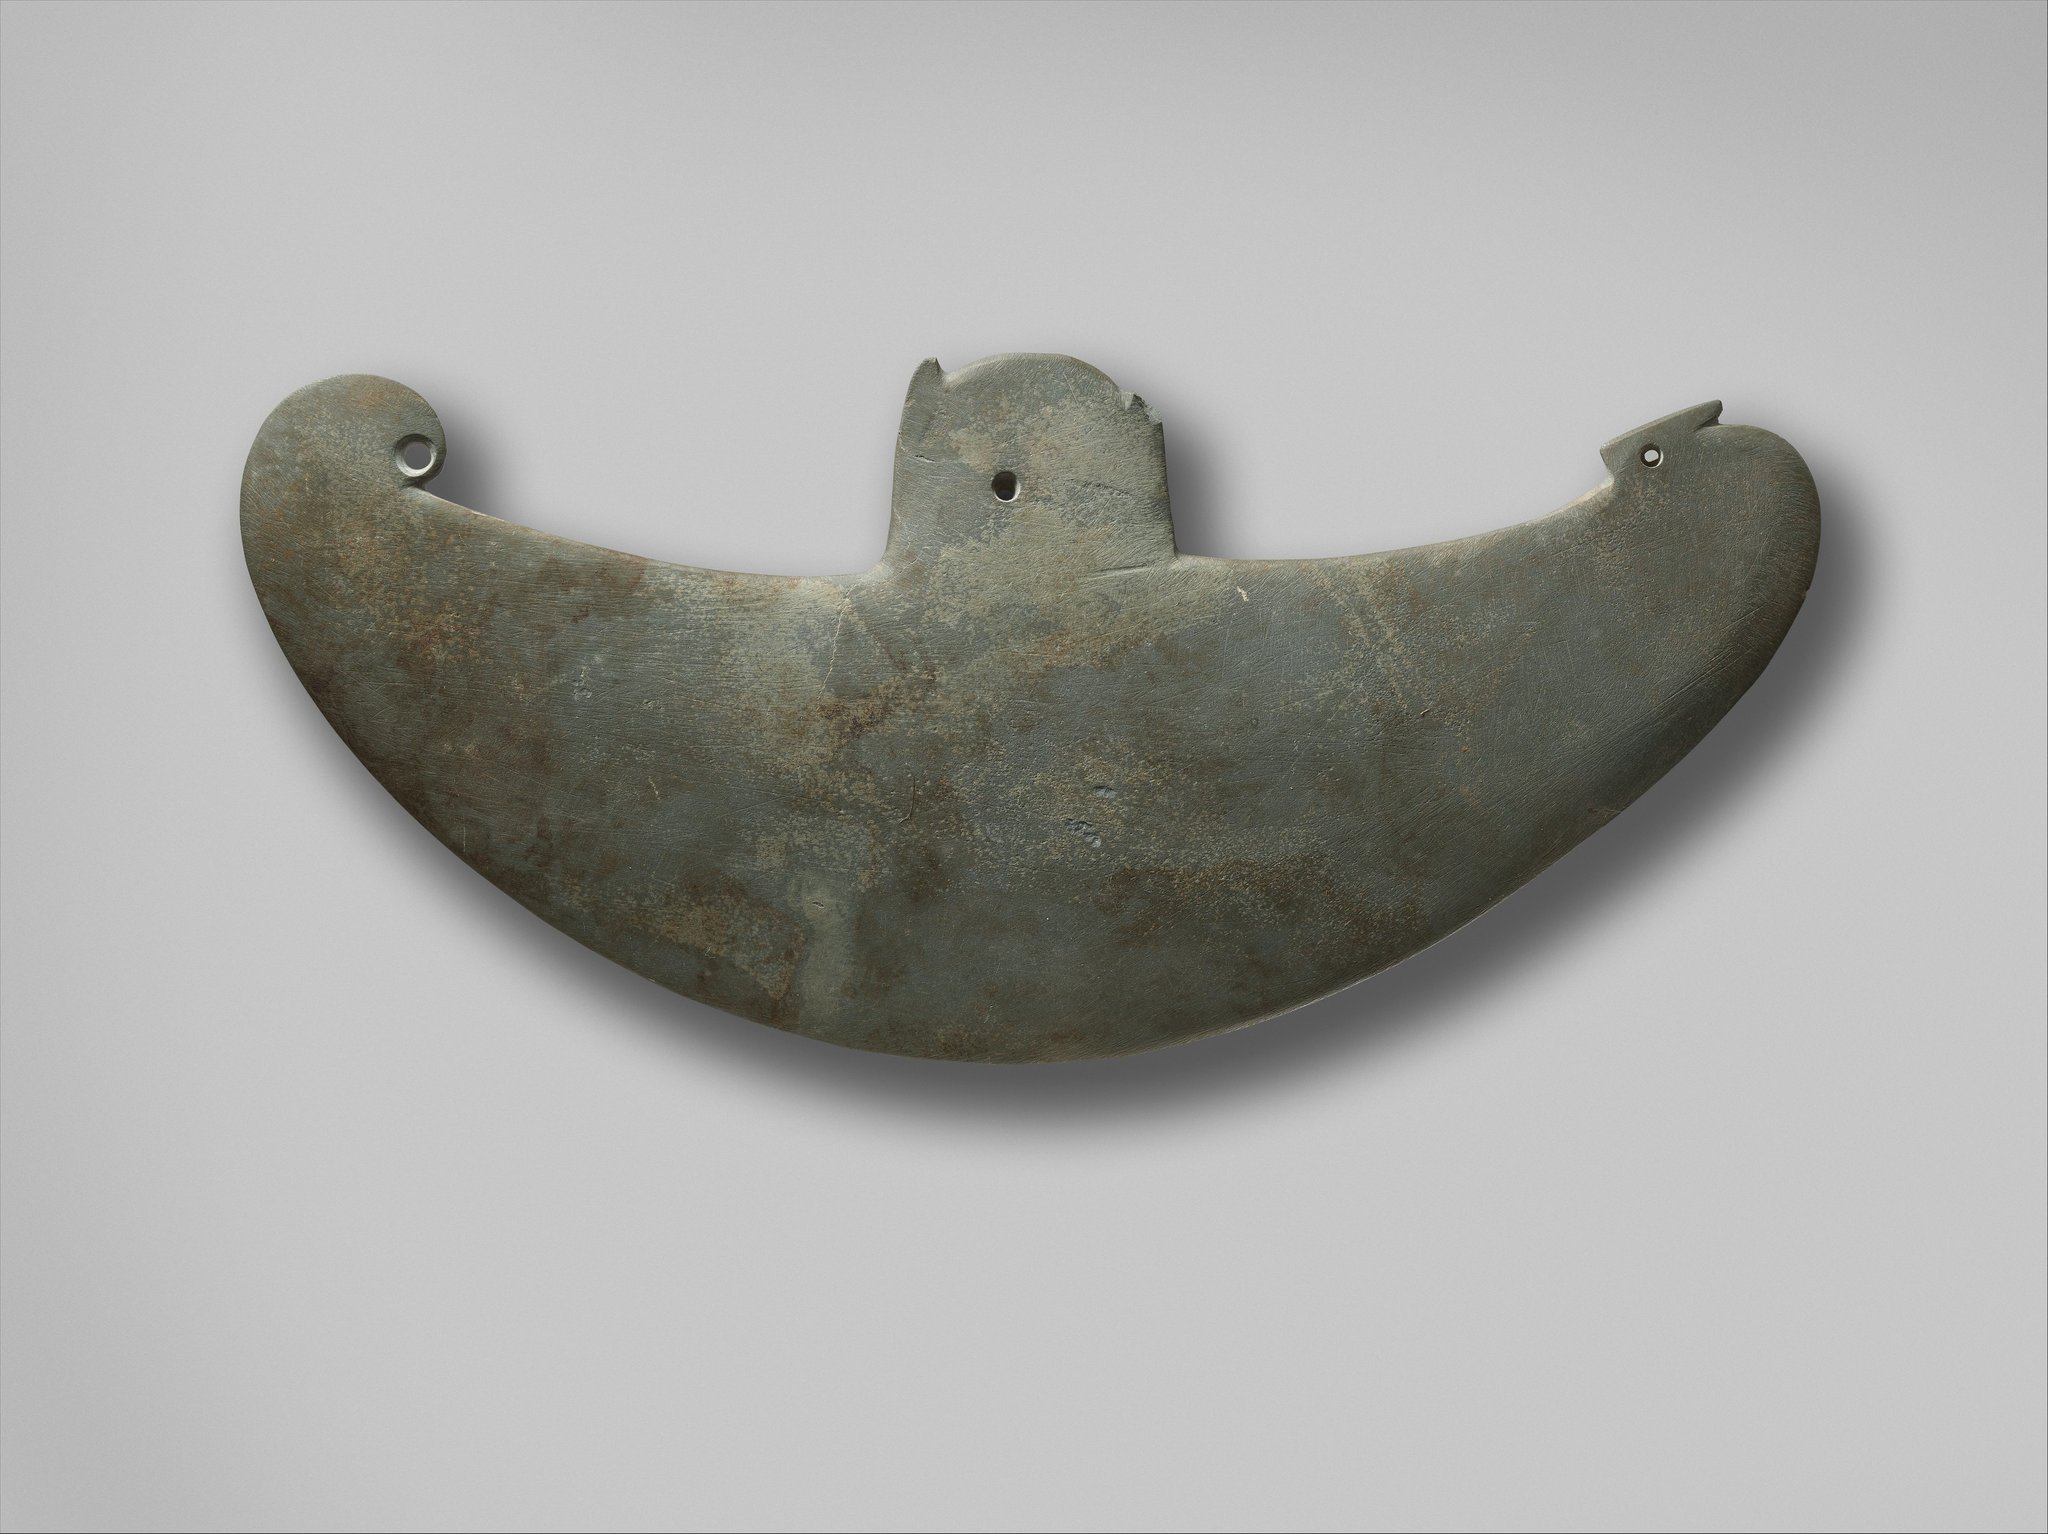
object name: palette, boat shaped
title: Boat-shaped palette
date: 3900-3500 BCE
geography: egypt